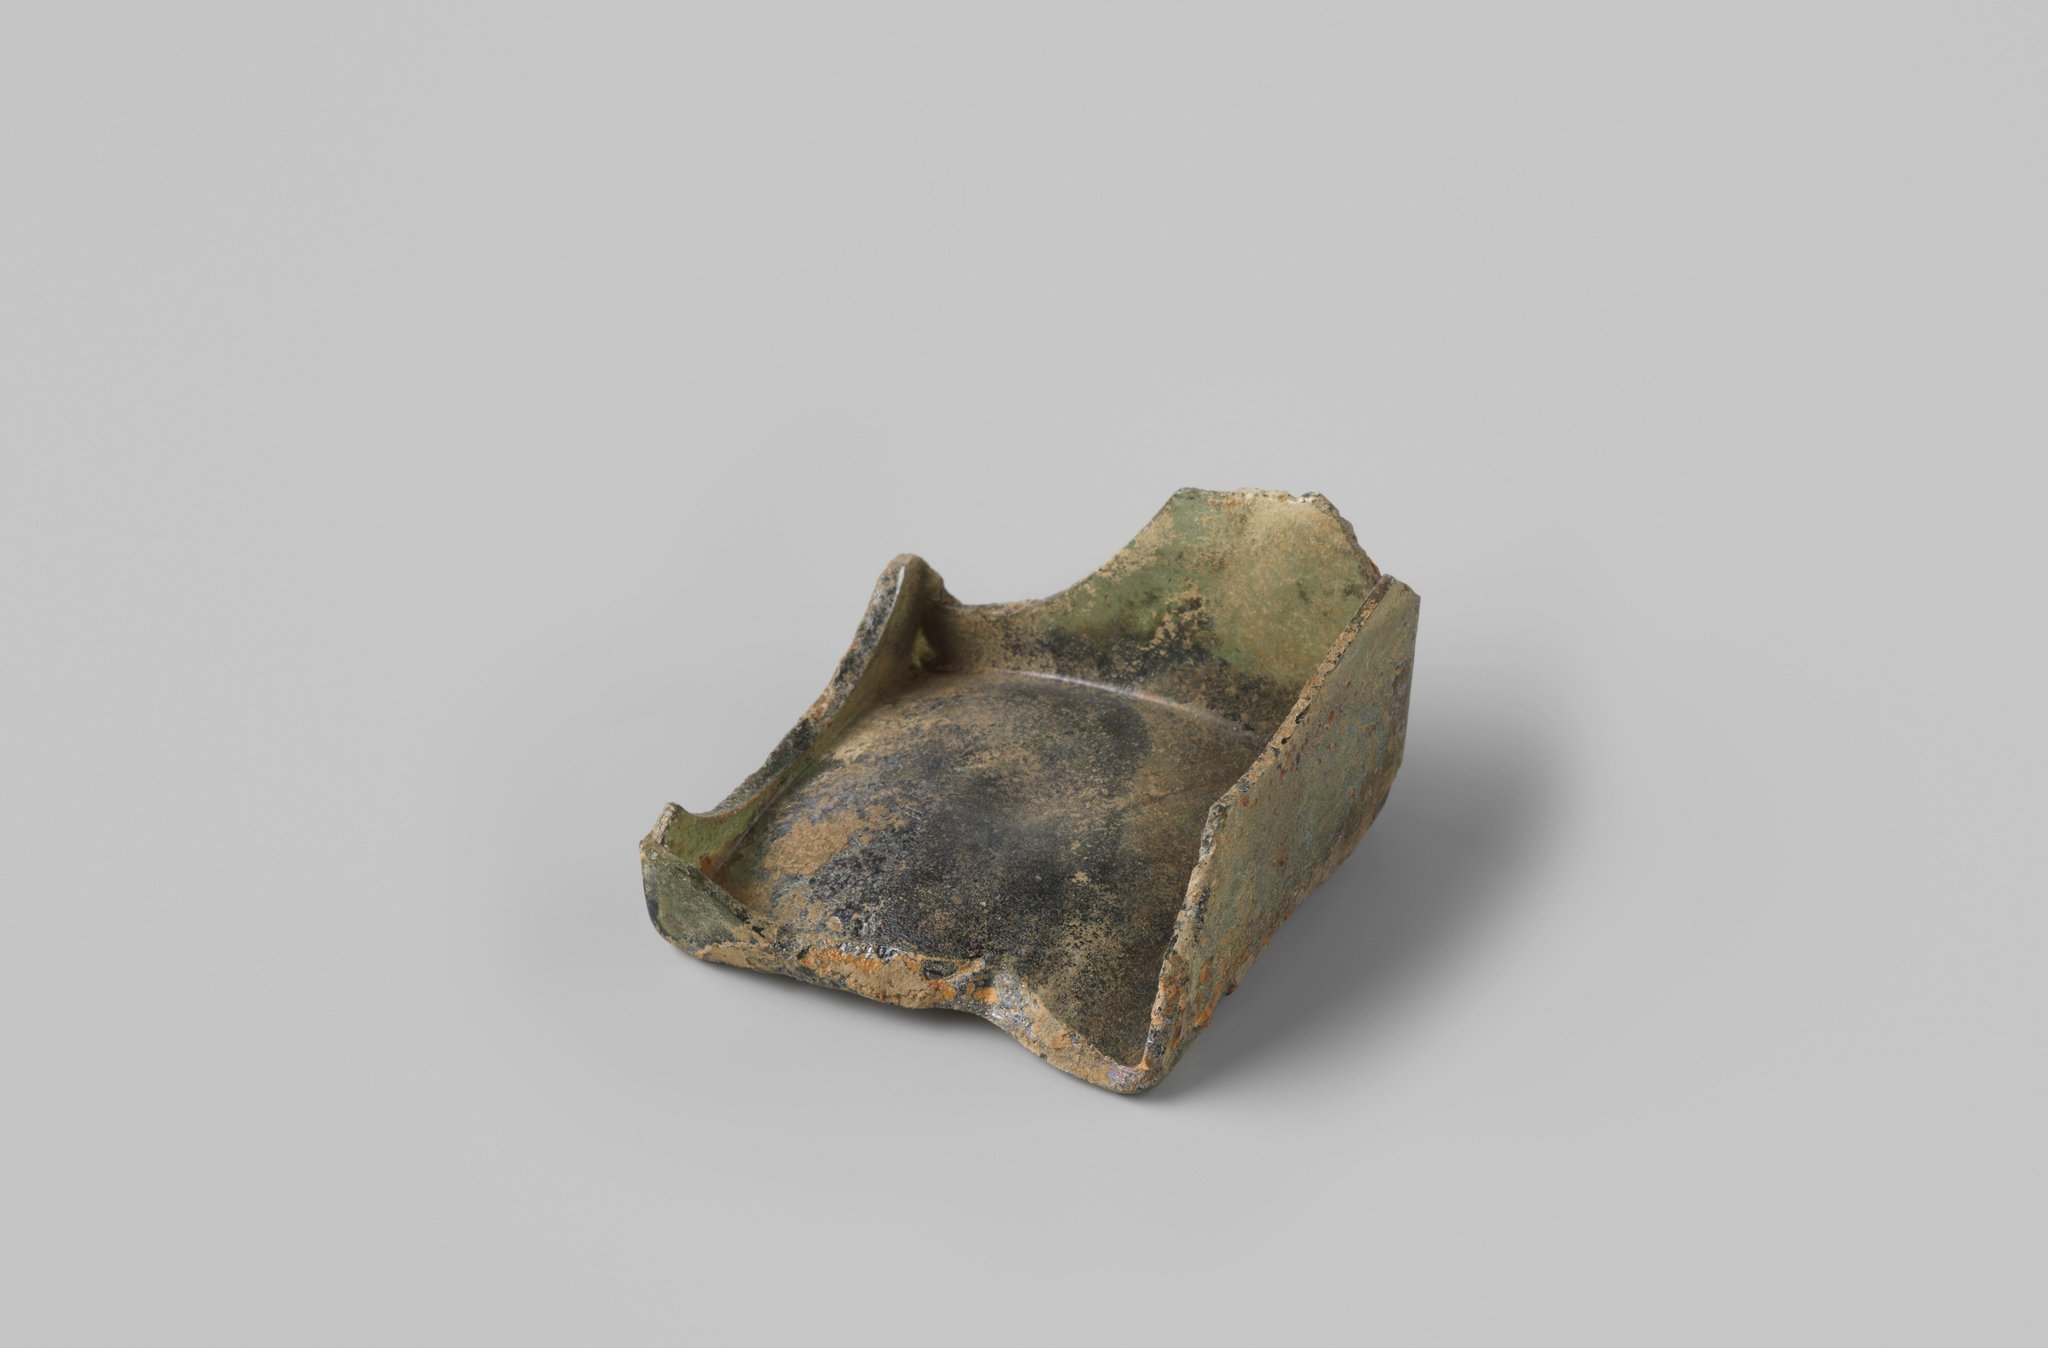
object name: case bottle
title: Fragment kelderfles uit een scheepswrak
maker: Anonymous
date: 1700-1735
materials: glass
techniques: green glass